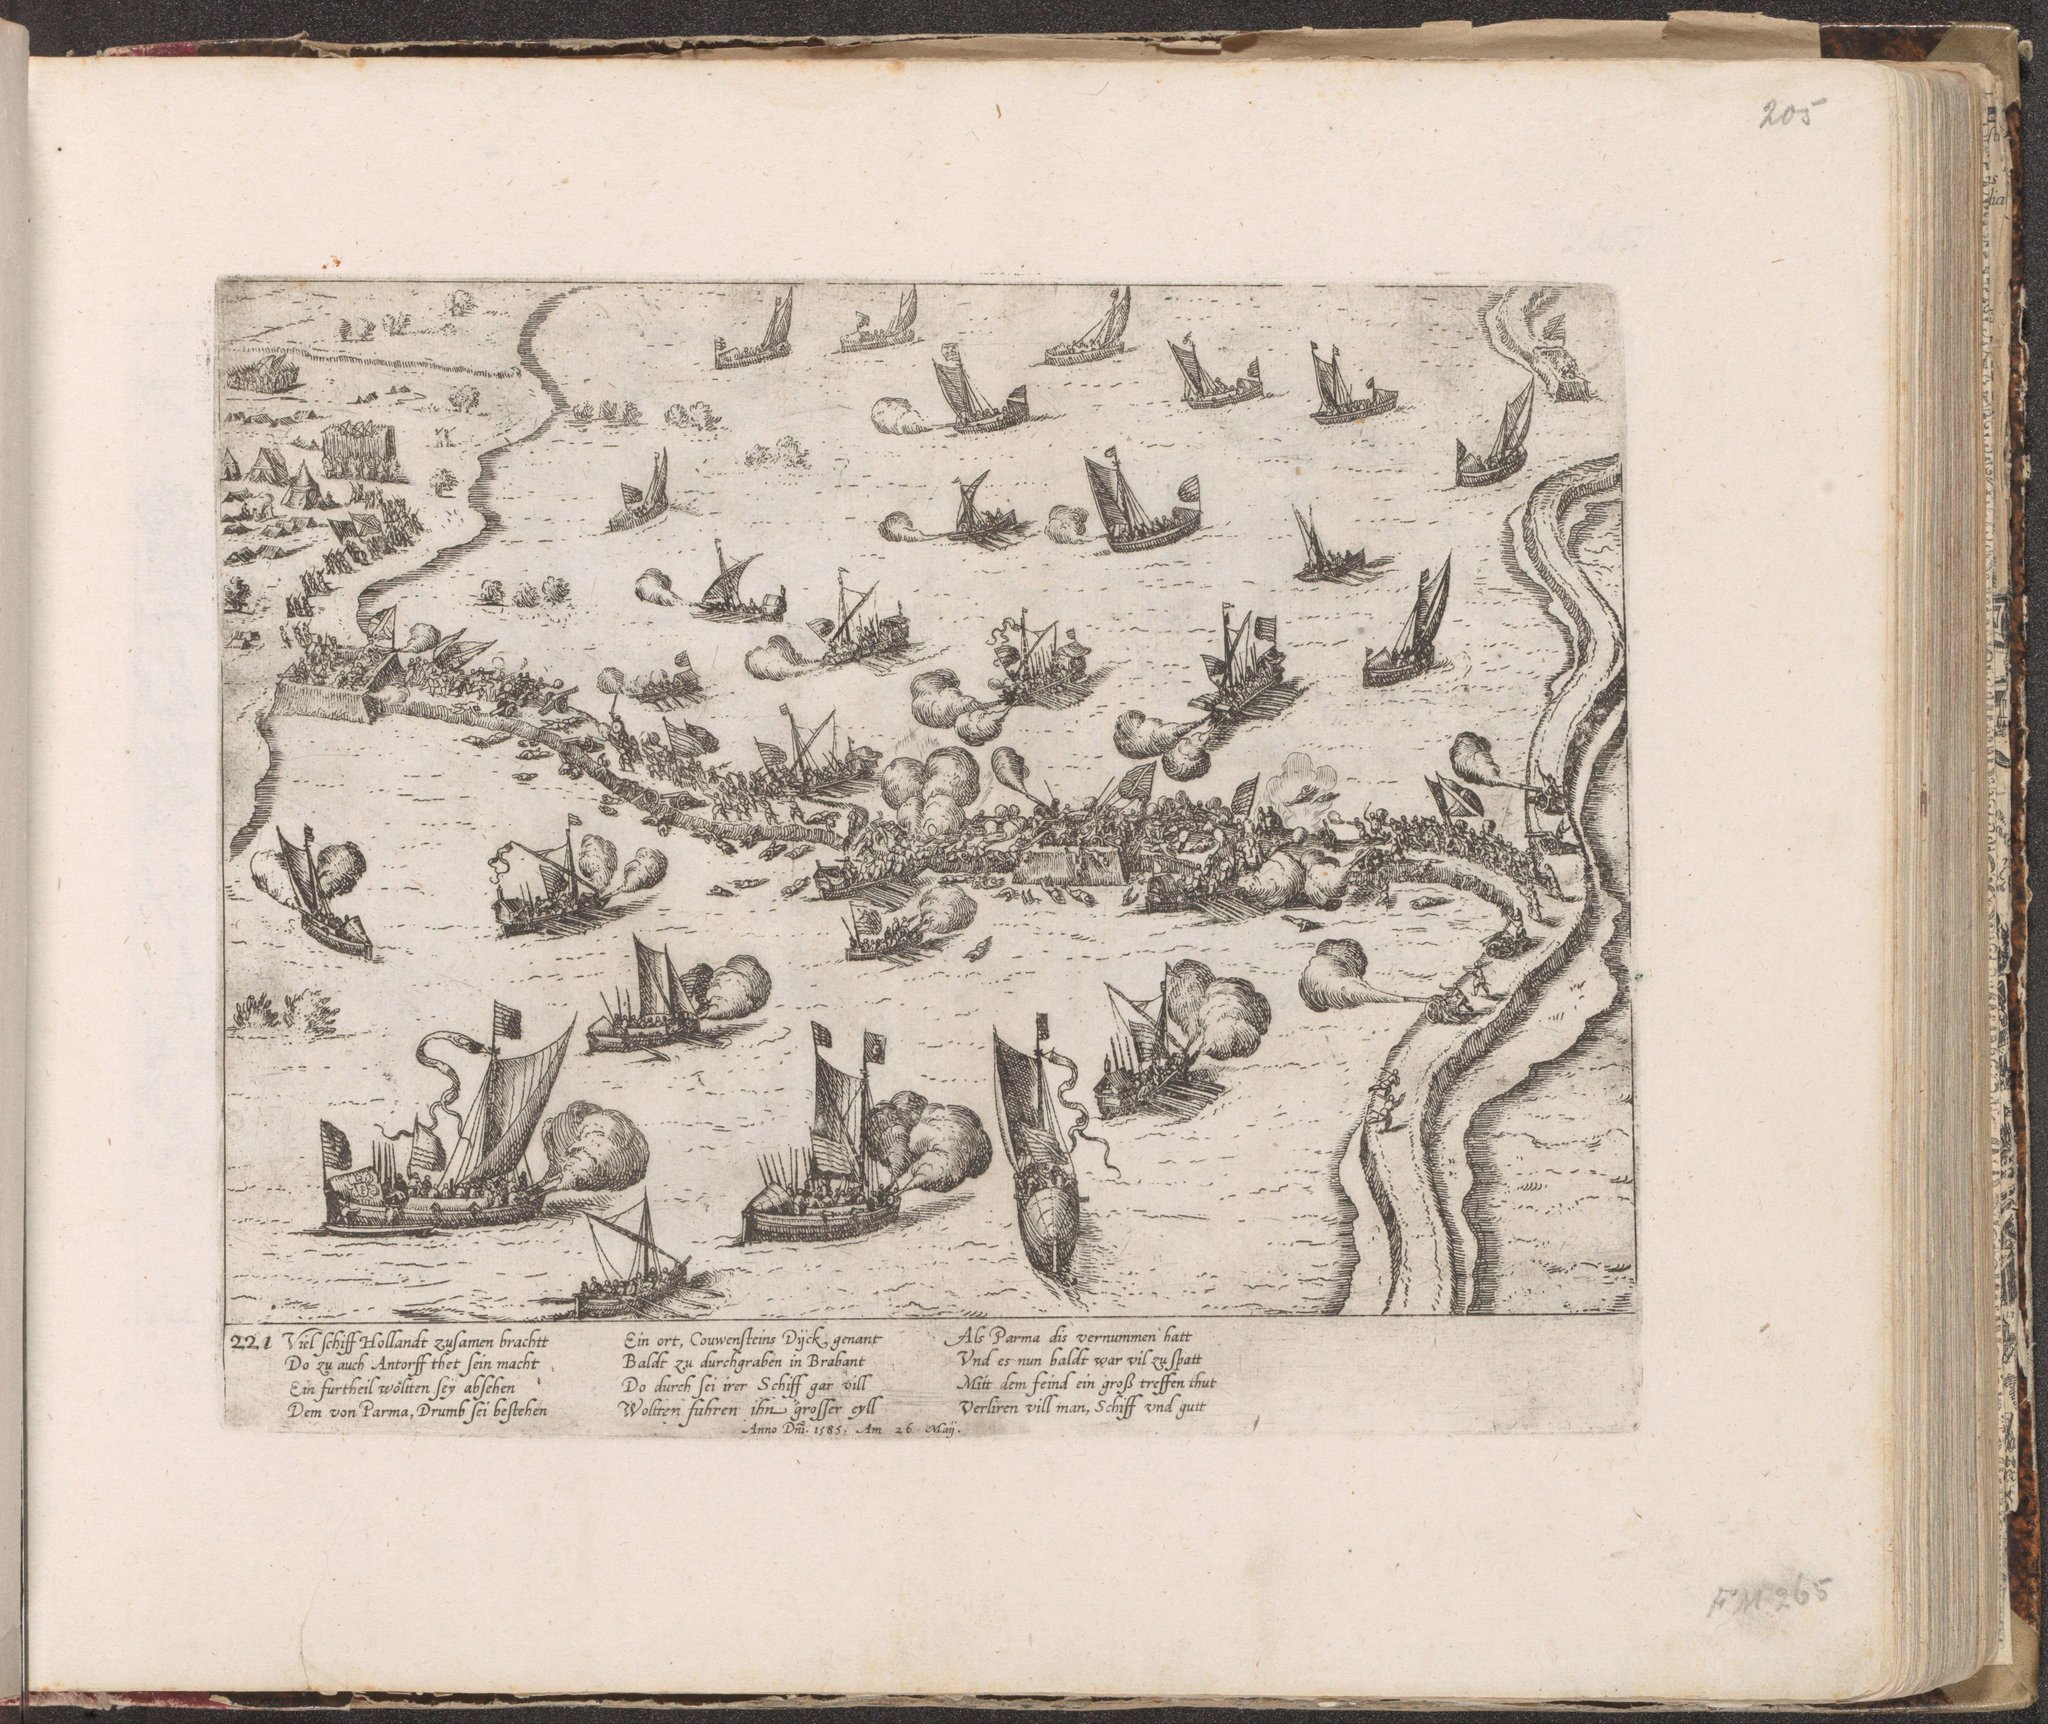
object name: history print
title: Serie 9: Nederlandse en Duitse Gebeurtenissen, 1583-1587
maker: frans hogenberg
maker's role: print maker, publisher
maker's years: 1538-1590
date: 1587-1591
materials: paper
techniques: etching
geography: cologne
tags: battle (+ land forces)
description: Slag op de Kauwensteinse dijk, 26 mei 1585. Aanval van het Staatse leger en Zeeuwse schepen op de dijk. Met onderschrift van 12 regels in het Duits. Linksonder genummerd: 221. De prent maakt deel uit van een album.